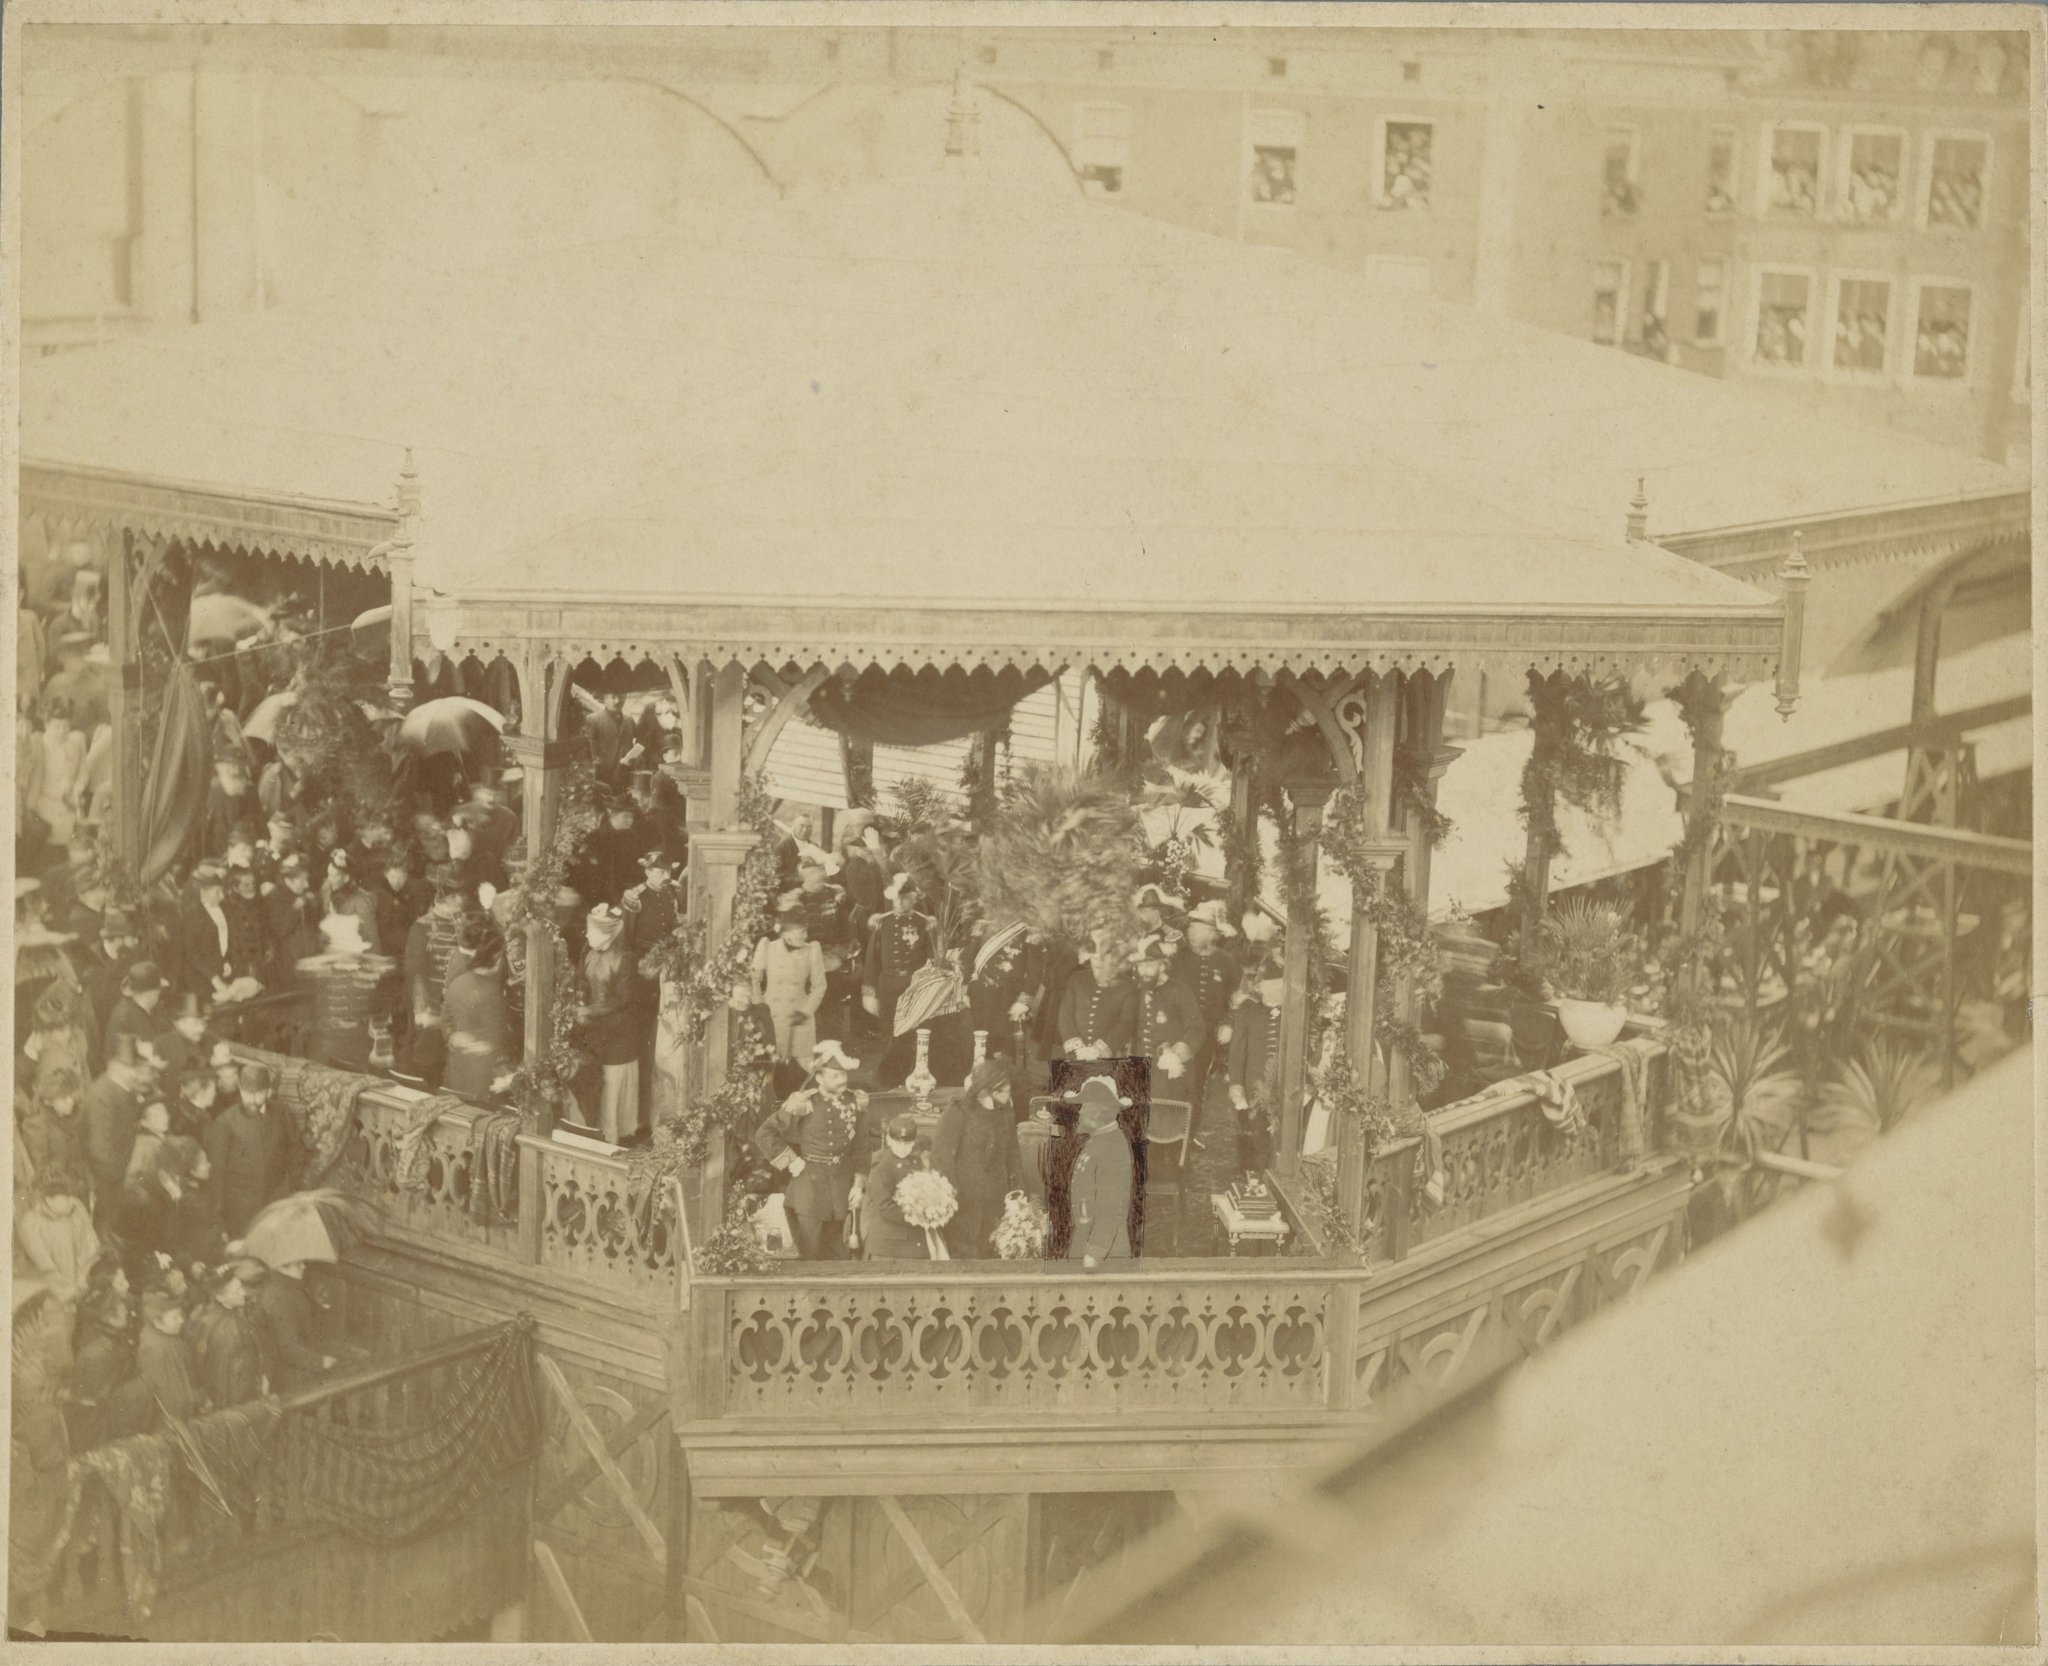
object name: photograph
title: Amsterdam, tewaterlating van oorlogsschip 'Wilhelmina' op de Marinewerf, met publiek en genodigden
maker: adrianus kok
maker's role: fotograaf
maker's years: 1852-1916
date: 1892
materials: cardboard, photographic support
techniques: albumen print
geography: amsterdam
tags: print maker, wilhelmina of the netherlands, the hague, emma (queen consort of the netherlands), amsterdam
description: in het midden van de foto naast koningin Wilhelmina en Koningin Emma is een hoge marinier later ingeplakt